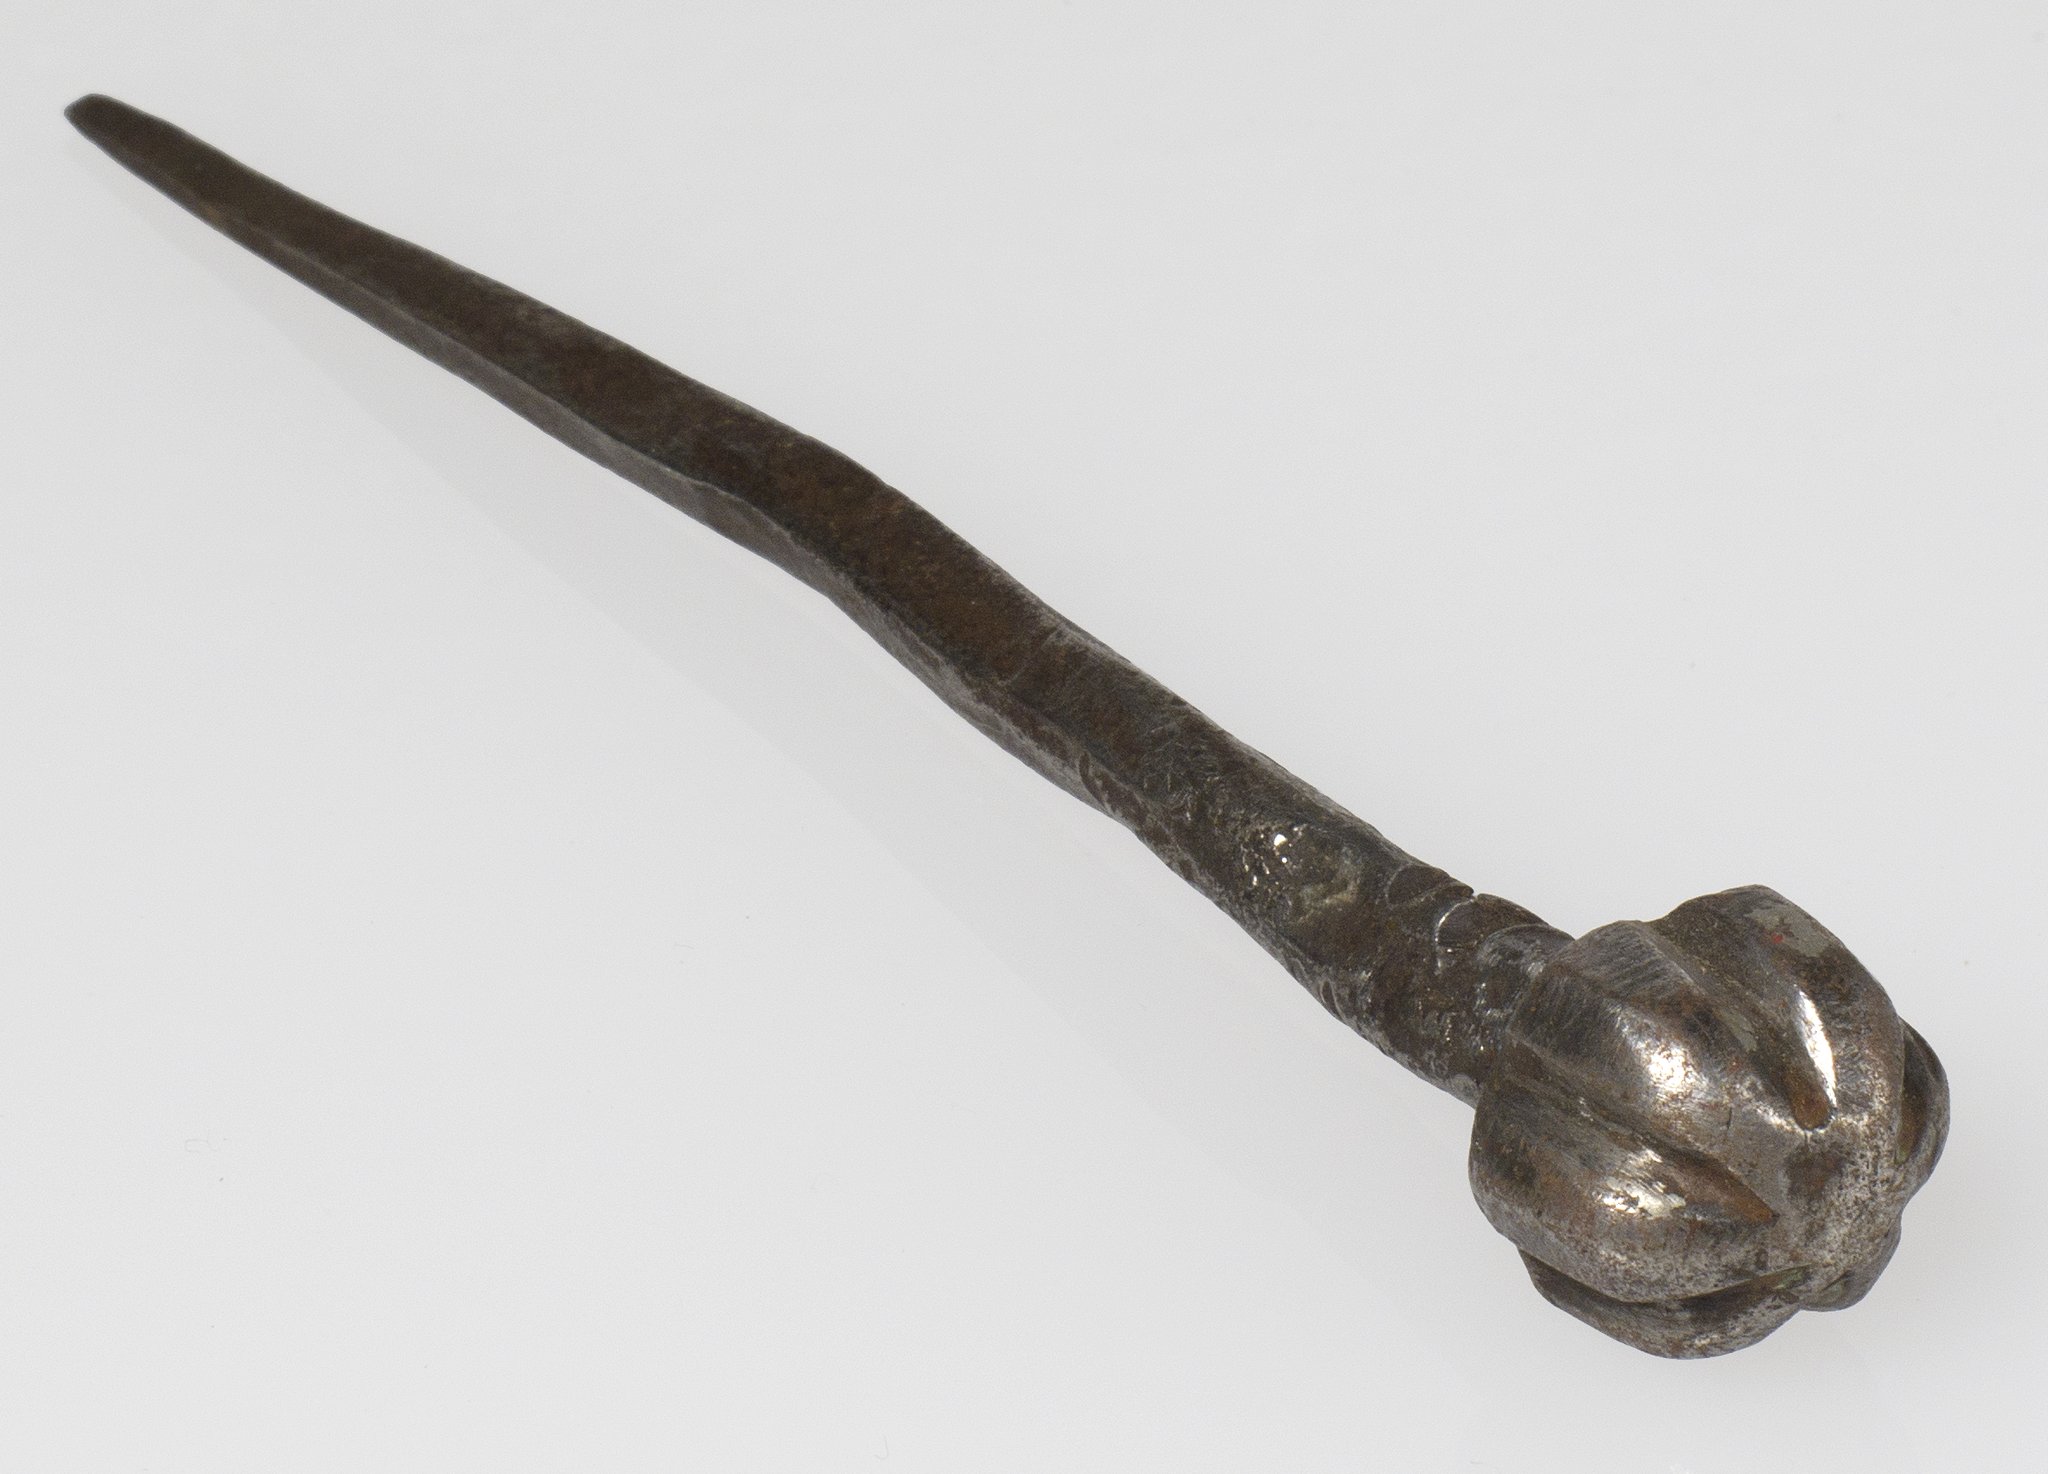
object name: nail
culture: european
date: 1401-1600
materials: iron